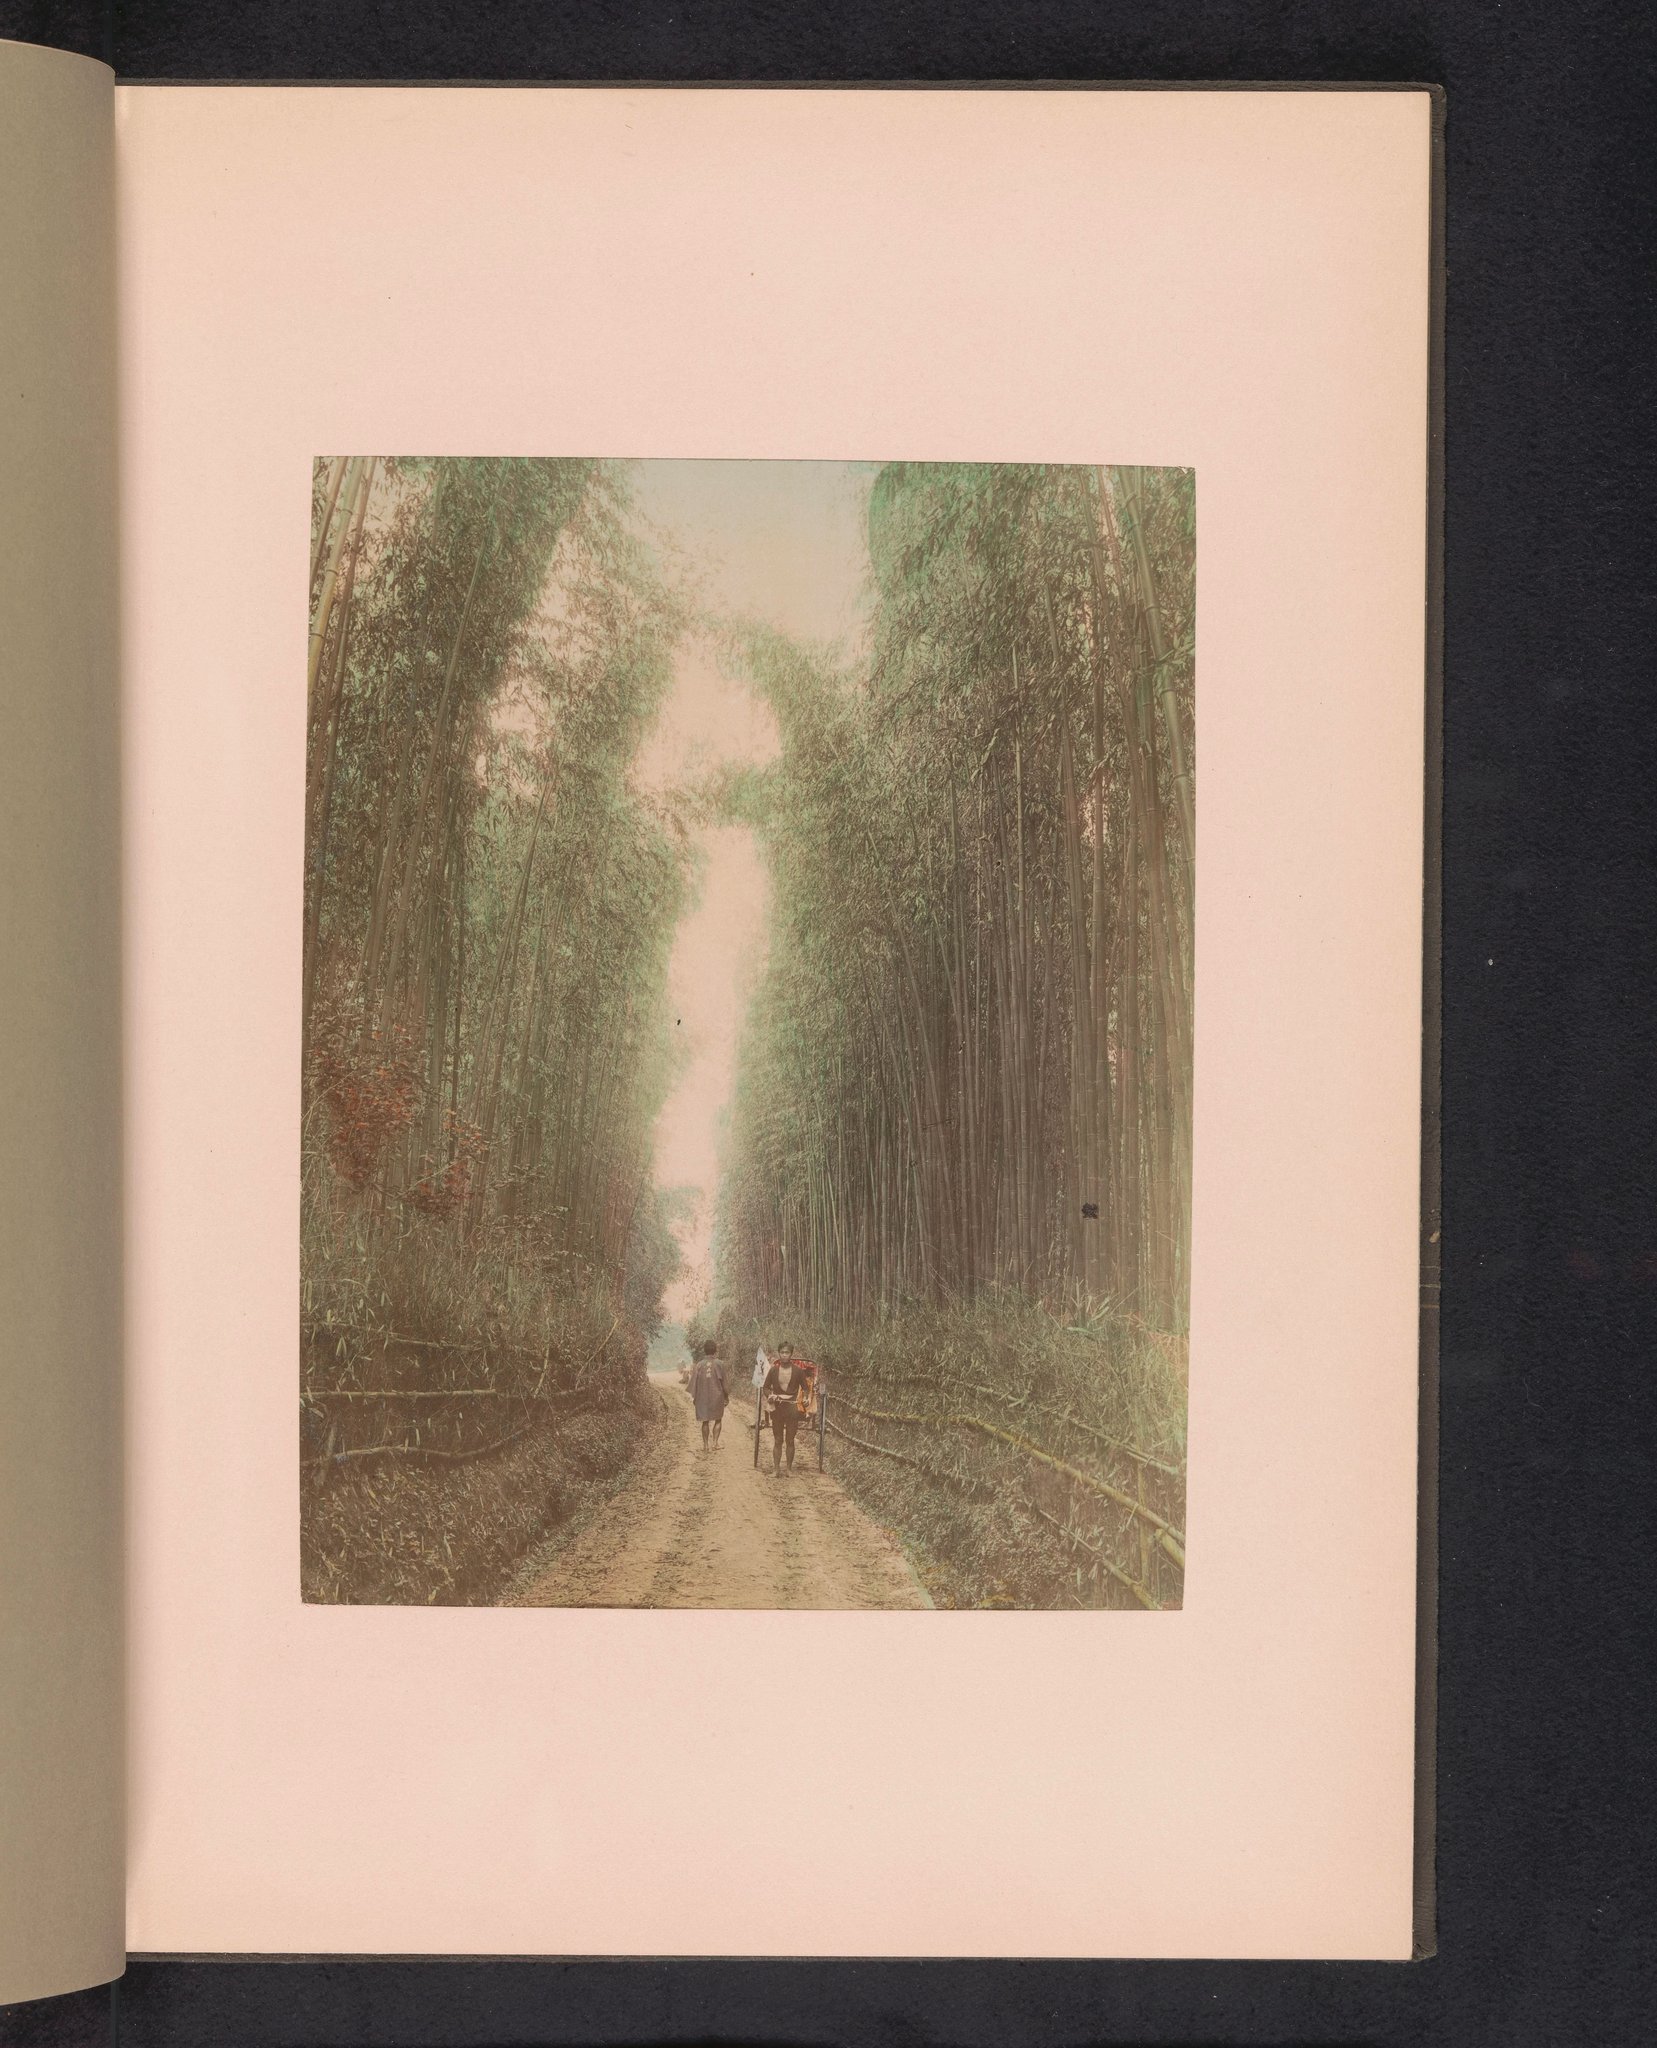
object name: photograph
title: Weg door een bamboebos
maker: Anonymous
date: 1887-1897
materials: photographic support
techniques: albumen print, hand coloring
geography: japan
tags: forest path or lane